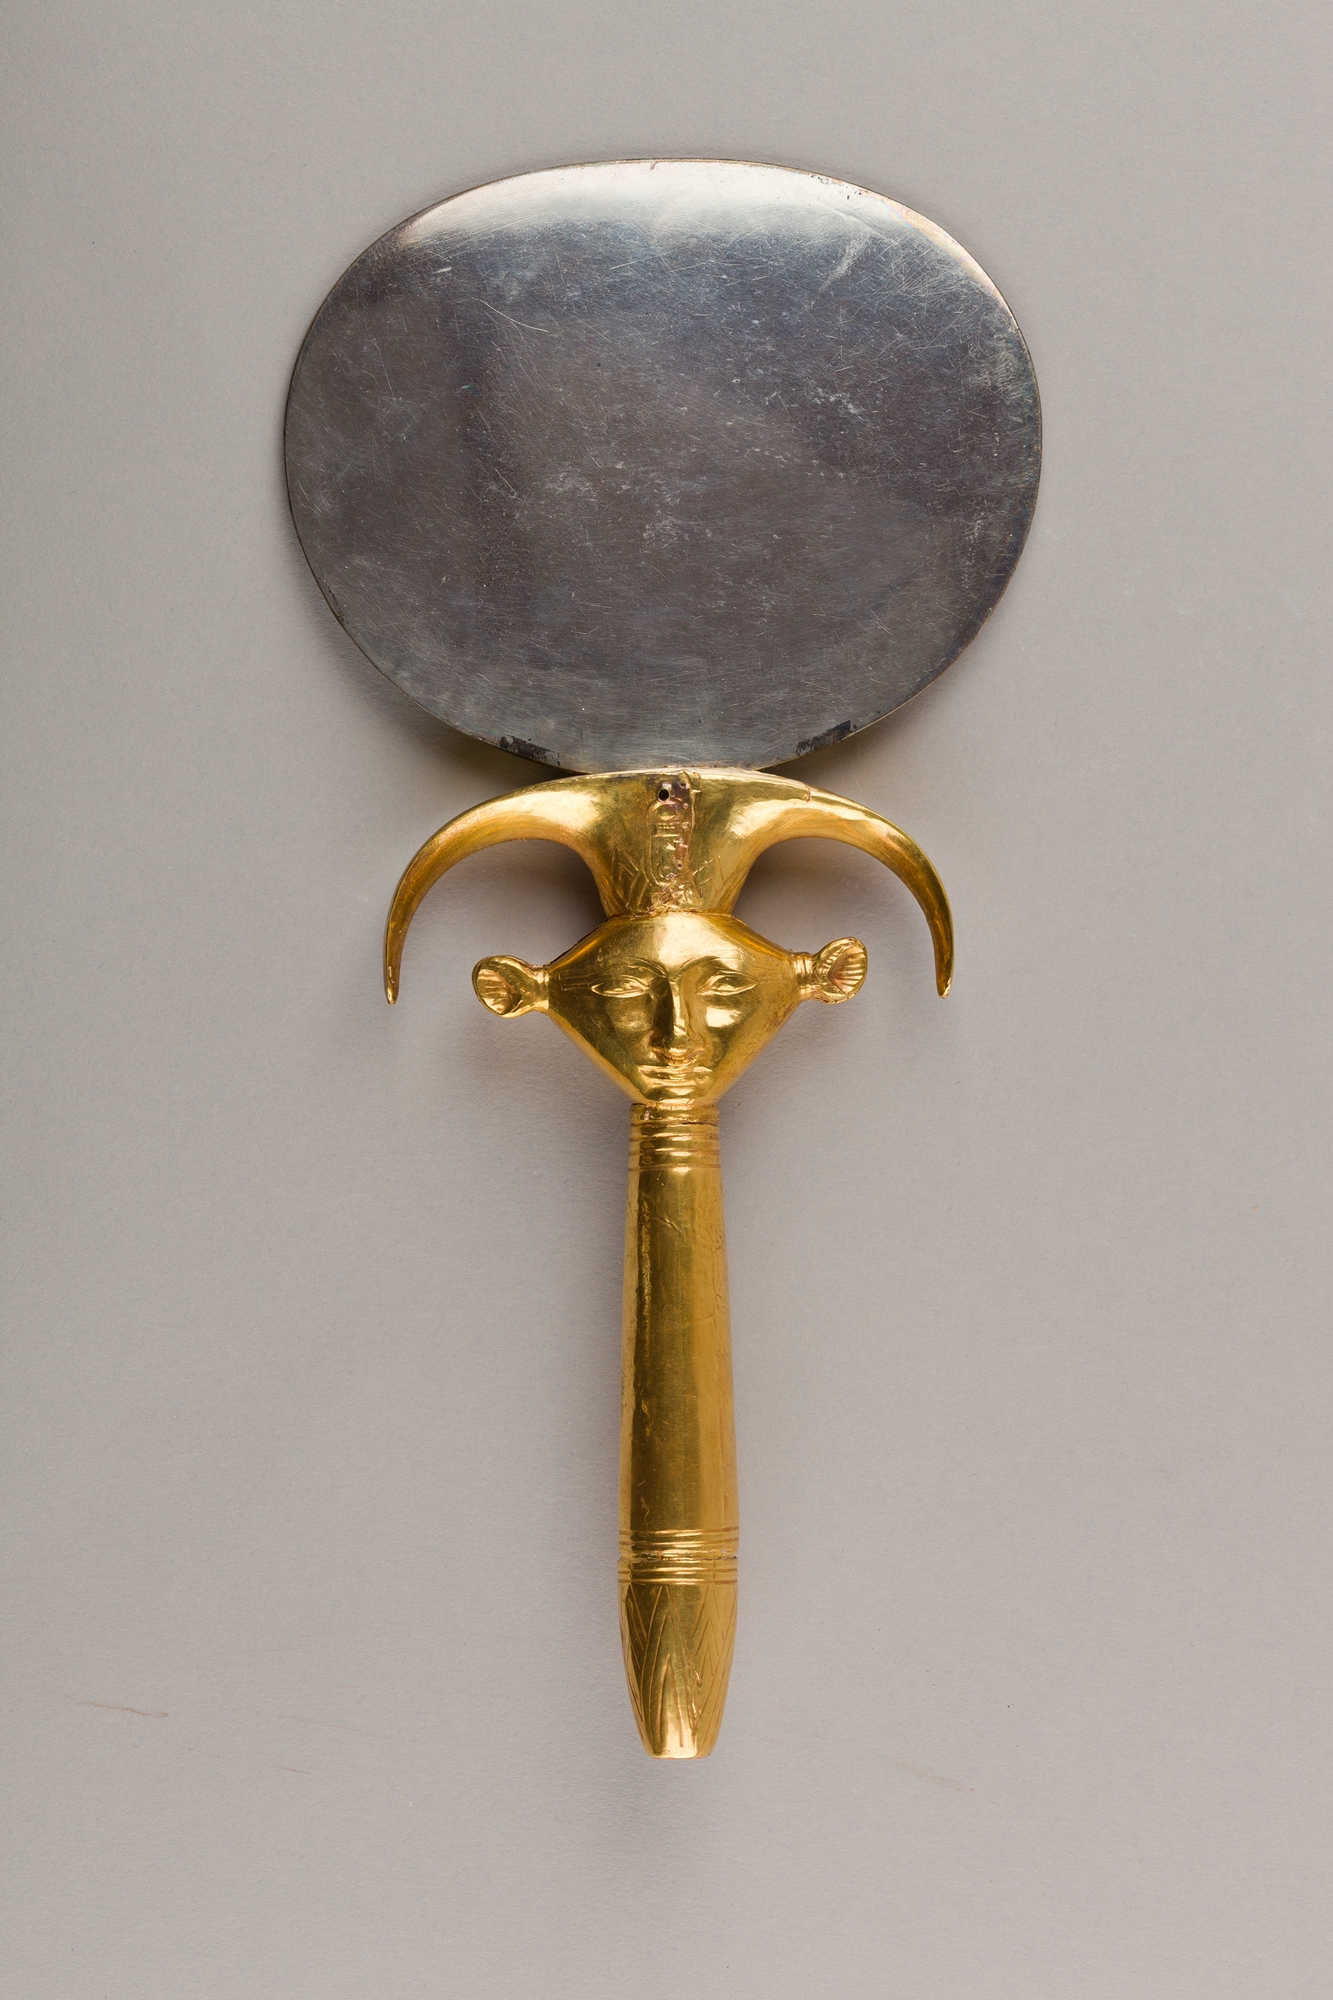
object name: mirror with a handle in the shape of the hathor emblem bat, thutmose iii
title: Mirror with Handle in the Form of a Hathor Emblem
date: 1479-1425 BCE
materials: gold, silver, wood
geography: egypt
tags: goddess